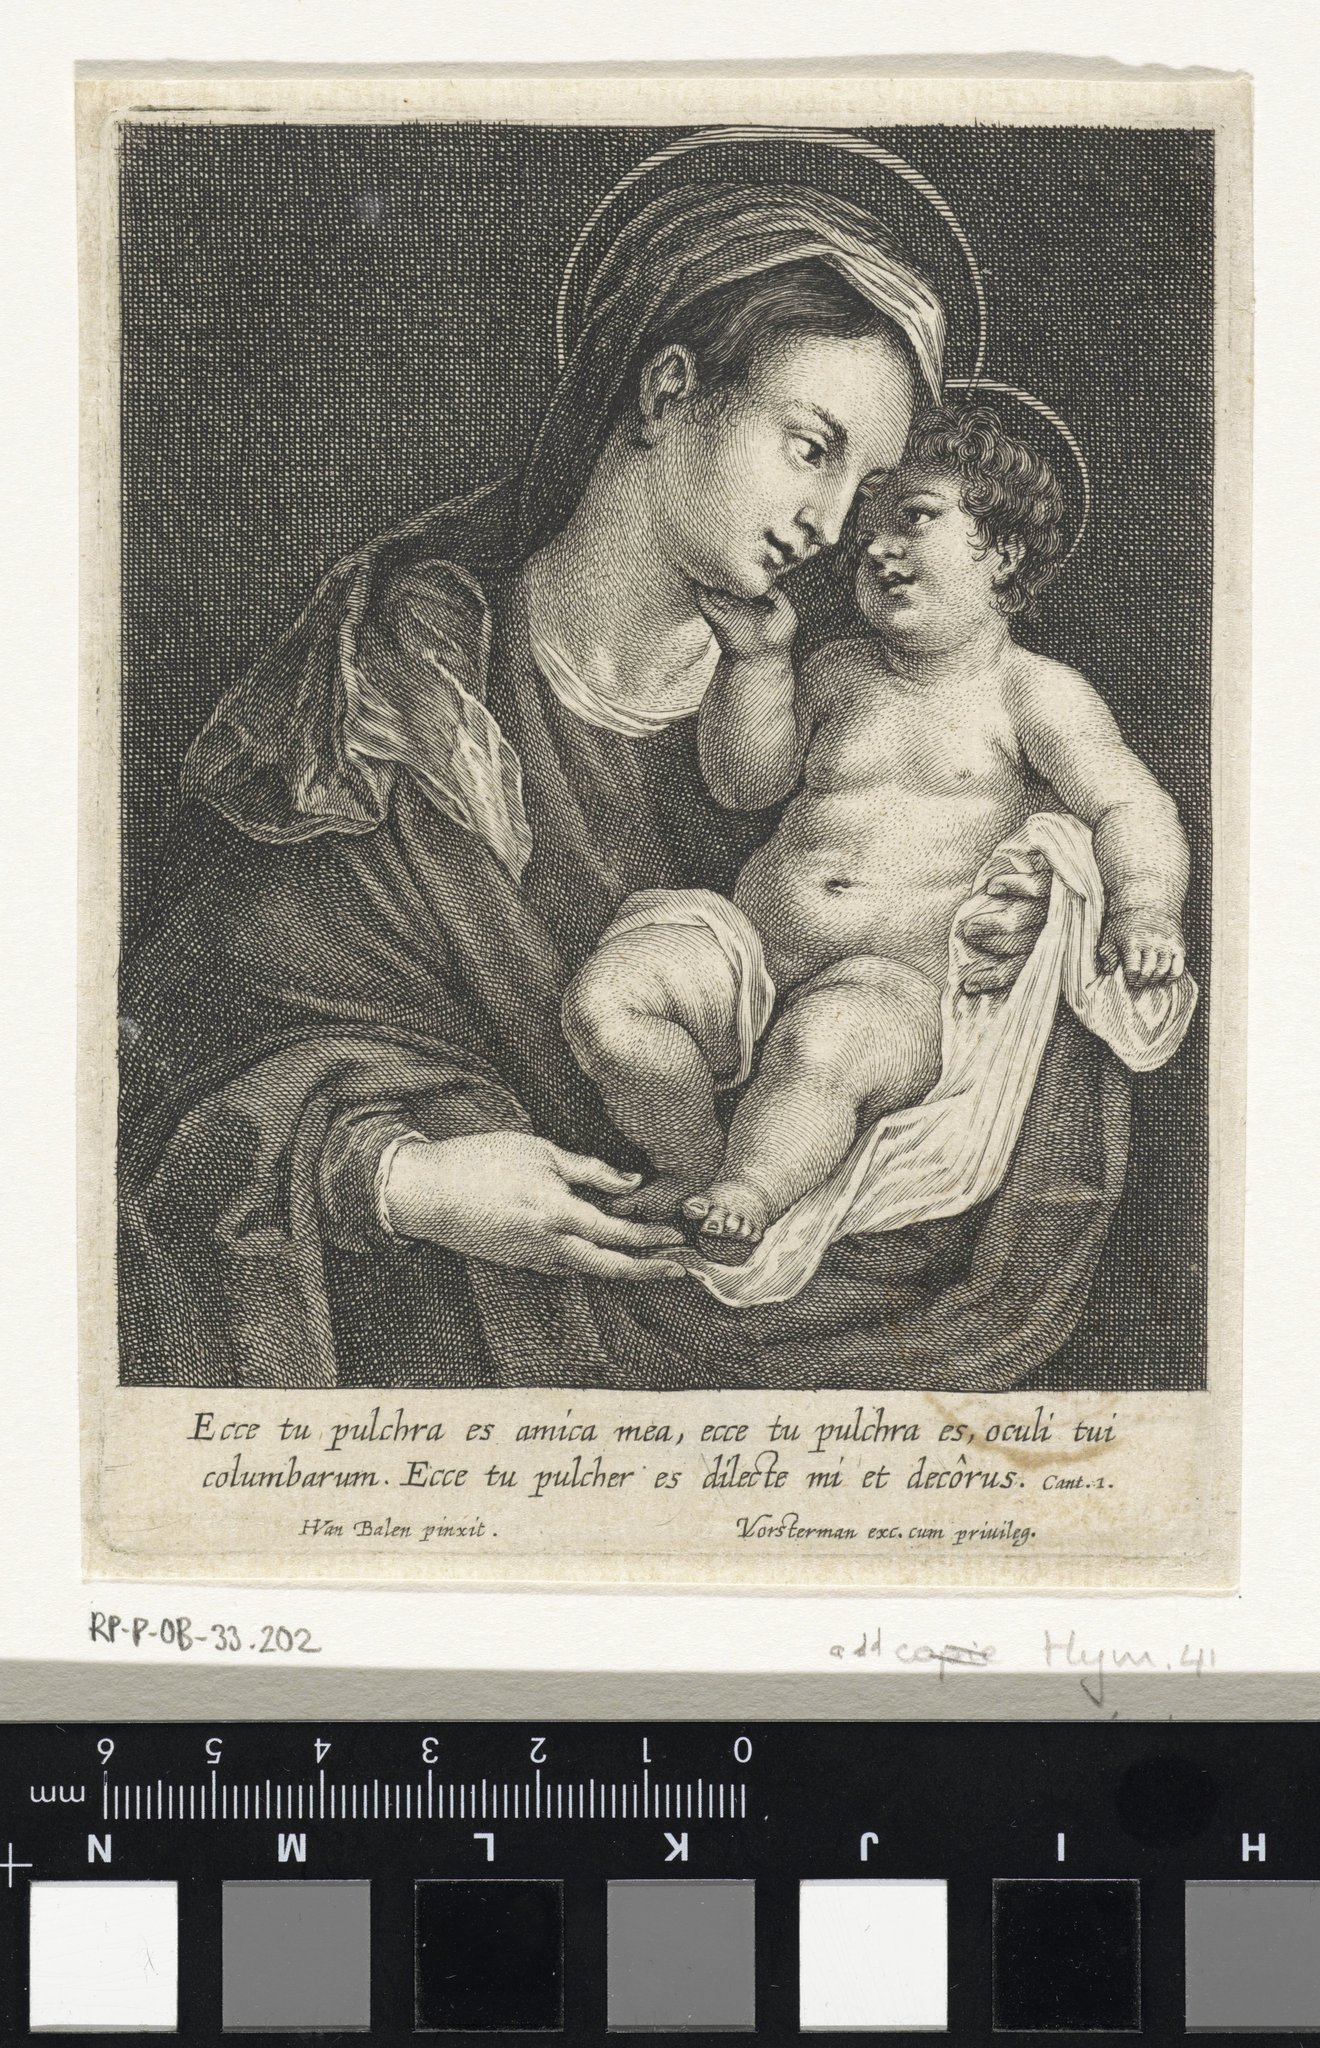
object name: print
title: Maria met Kind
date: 1619-1675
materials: paper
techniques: engraving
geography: antwerp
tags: madonna: i.e. mary with the christ-child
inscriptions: collector's mark: Lugt 240